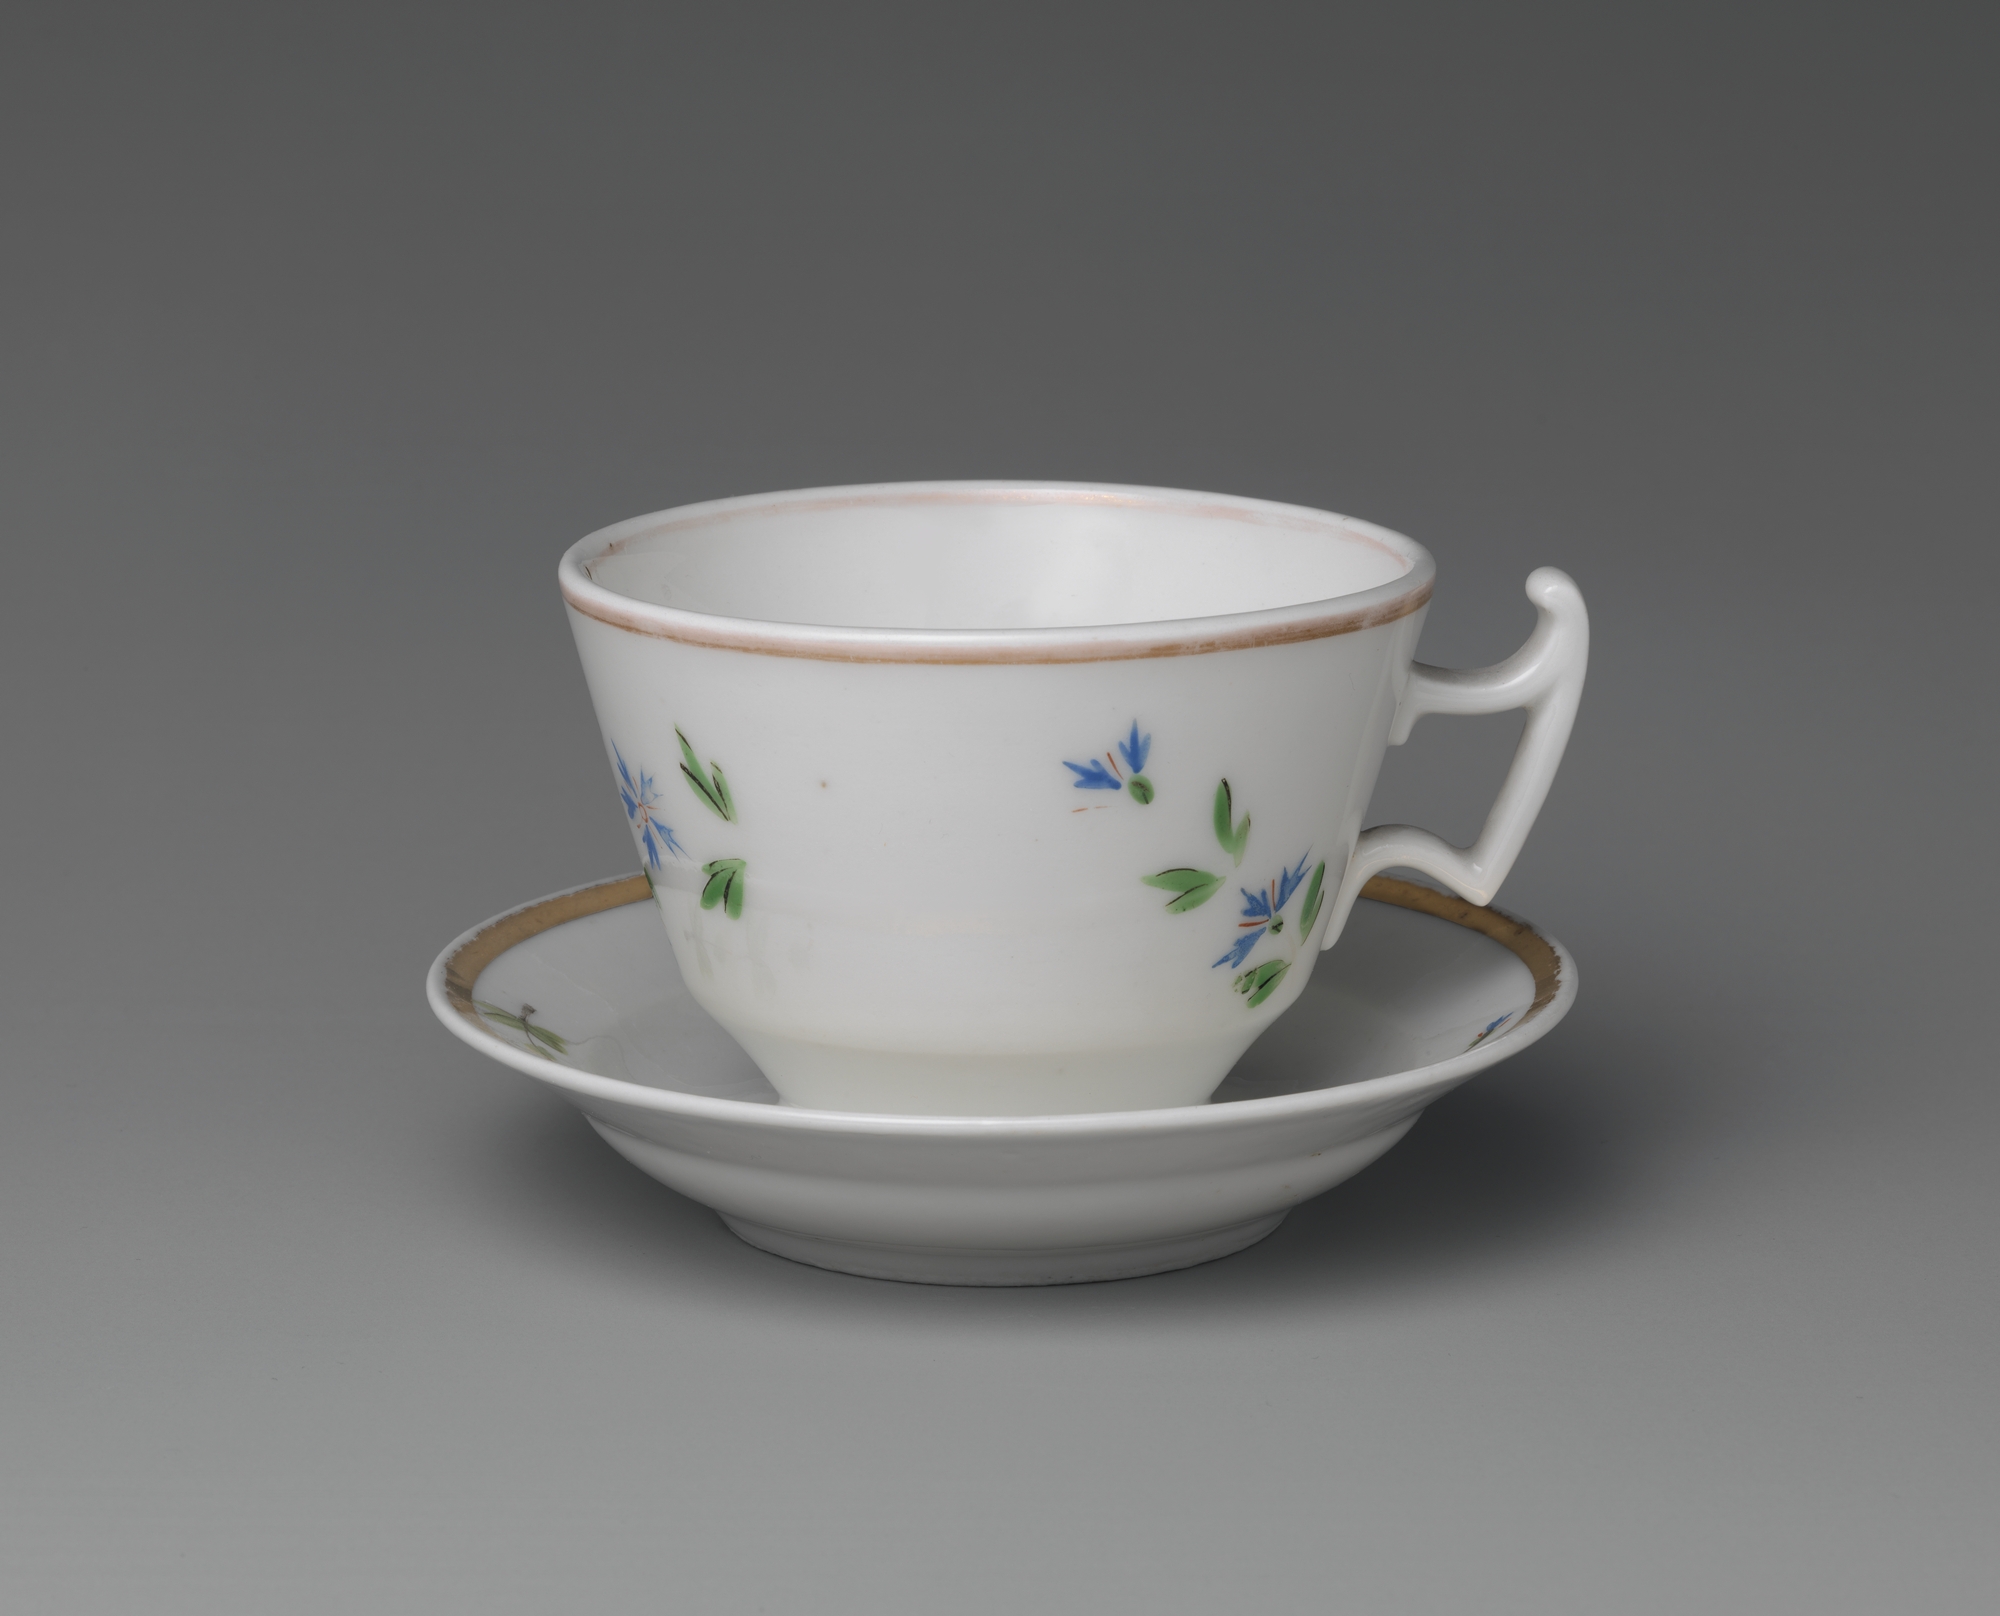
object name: cup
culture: french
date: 1815-1830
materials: porcelain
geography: france